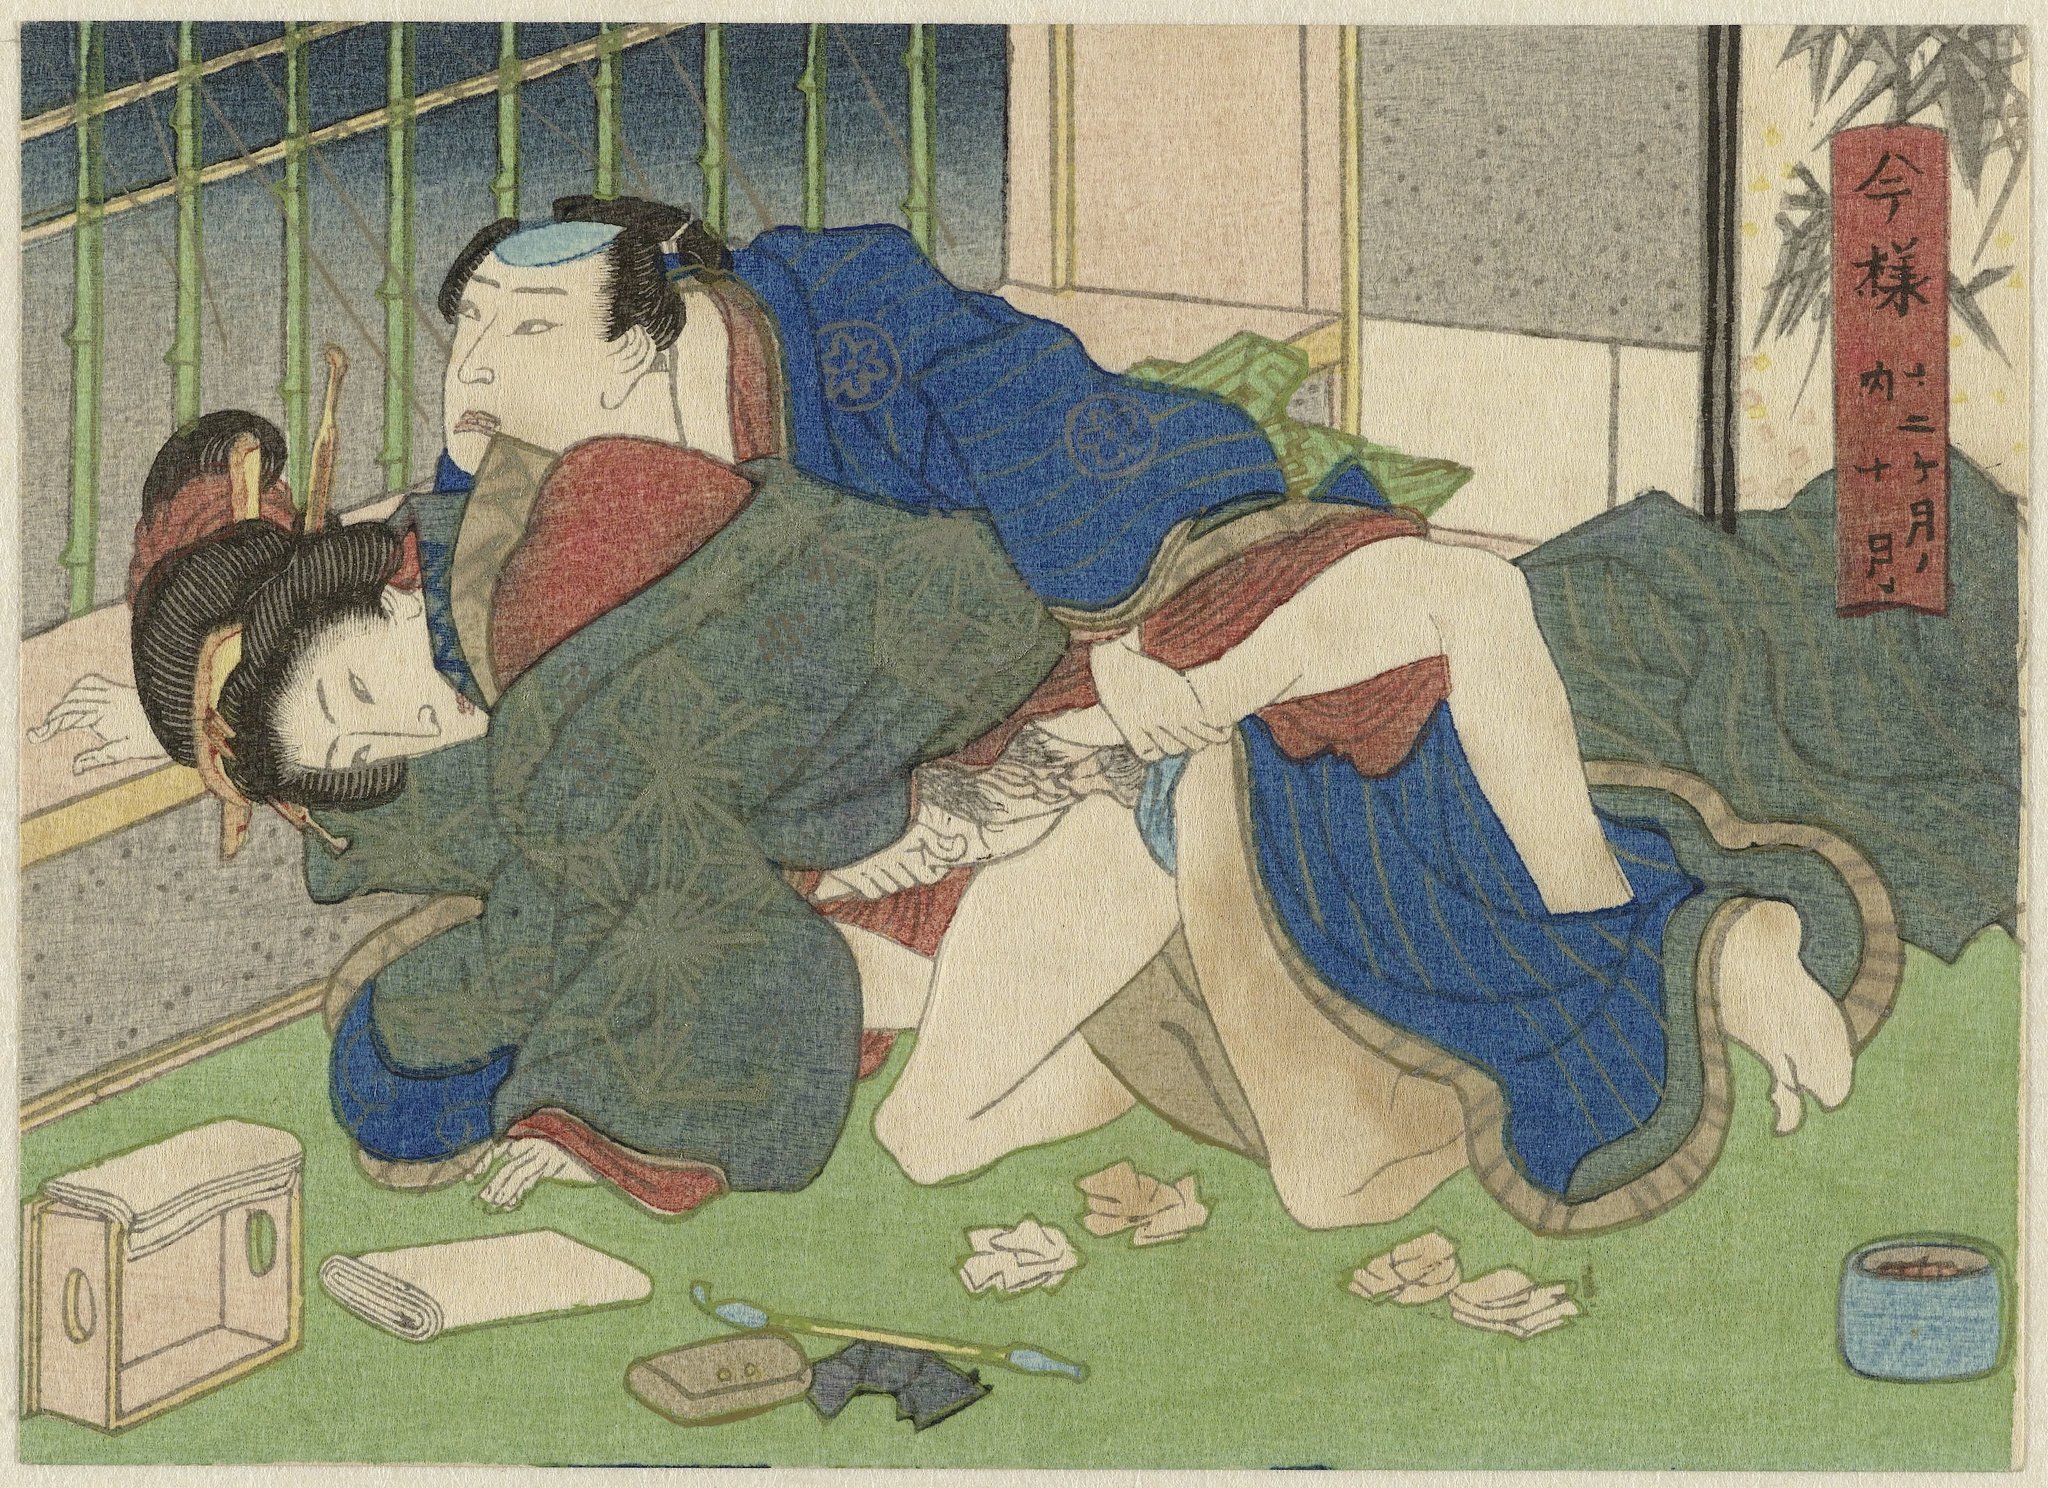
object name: print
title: Jûgatsu, de tiende maand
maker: Anonymous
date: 1835-1845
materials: paper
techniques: woodcut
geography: japan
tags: the twelve months of the year represented by concepts other than personifications, human activities, landscapes, or still lifes of flowers and/or fruits, coitus, cohabiting, sexual intercourse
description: Een man in een helblauwe kimono neemt zijn gezellin van achteren. De avondlucht is zichtbaar door het venster. De vele papiertjes - hanagami - op de grond getuigen van herhaalde seksuele activiteit.